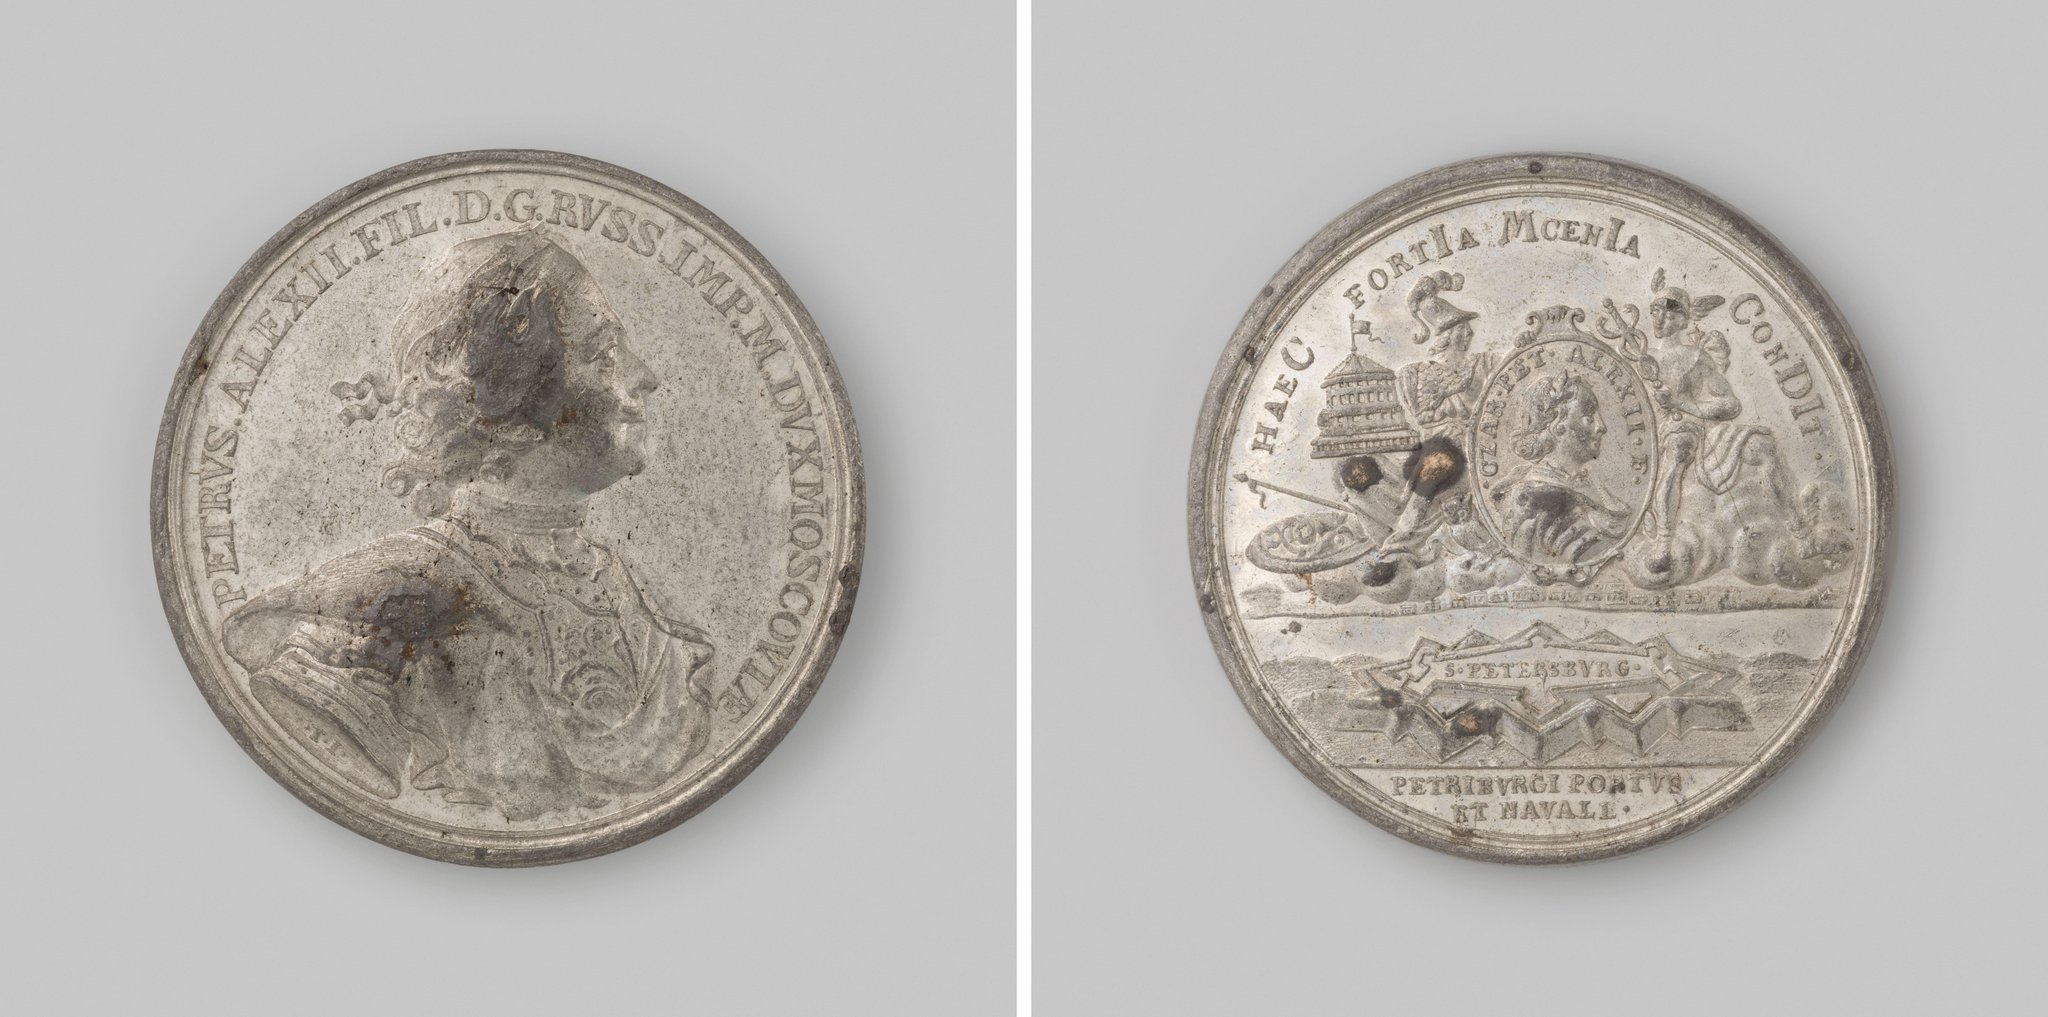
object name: history medal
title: Stichting van Sint-Petersburg door Tsaar Peter de Grote 1703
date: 1703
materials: tin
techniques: striking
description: Tinnen penning, op de voorzijde het borstbeeld van Tsaar Peter de Grote naar rechts met omschrift, op de keerzijde het kasteel van Sint Petersburg waarboven de zittende Pallas en Mercurius met een medaillon met het portret van Tsaar Peter de Grote naar rechts, met omschrift en afsnedetekst.